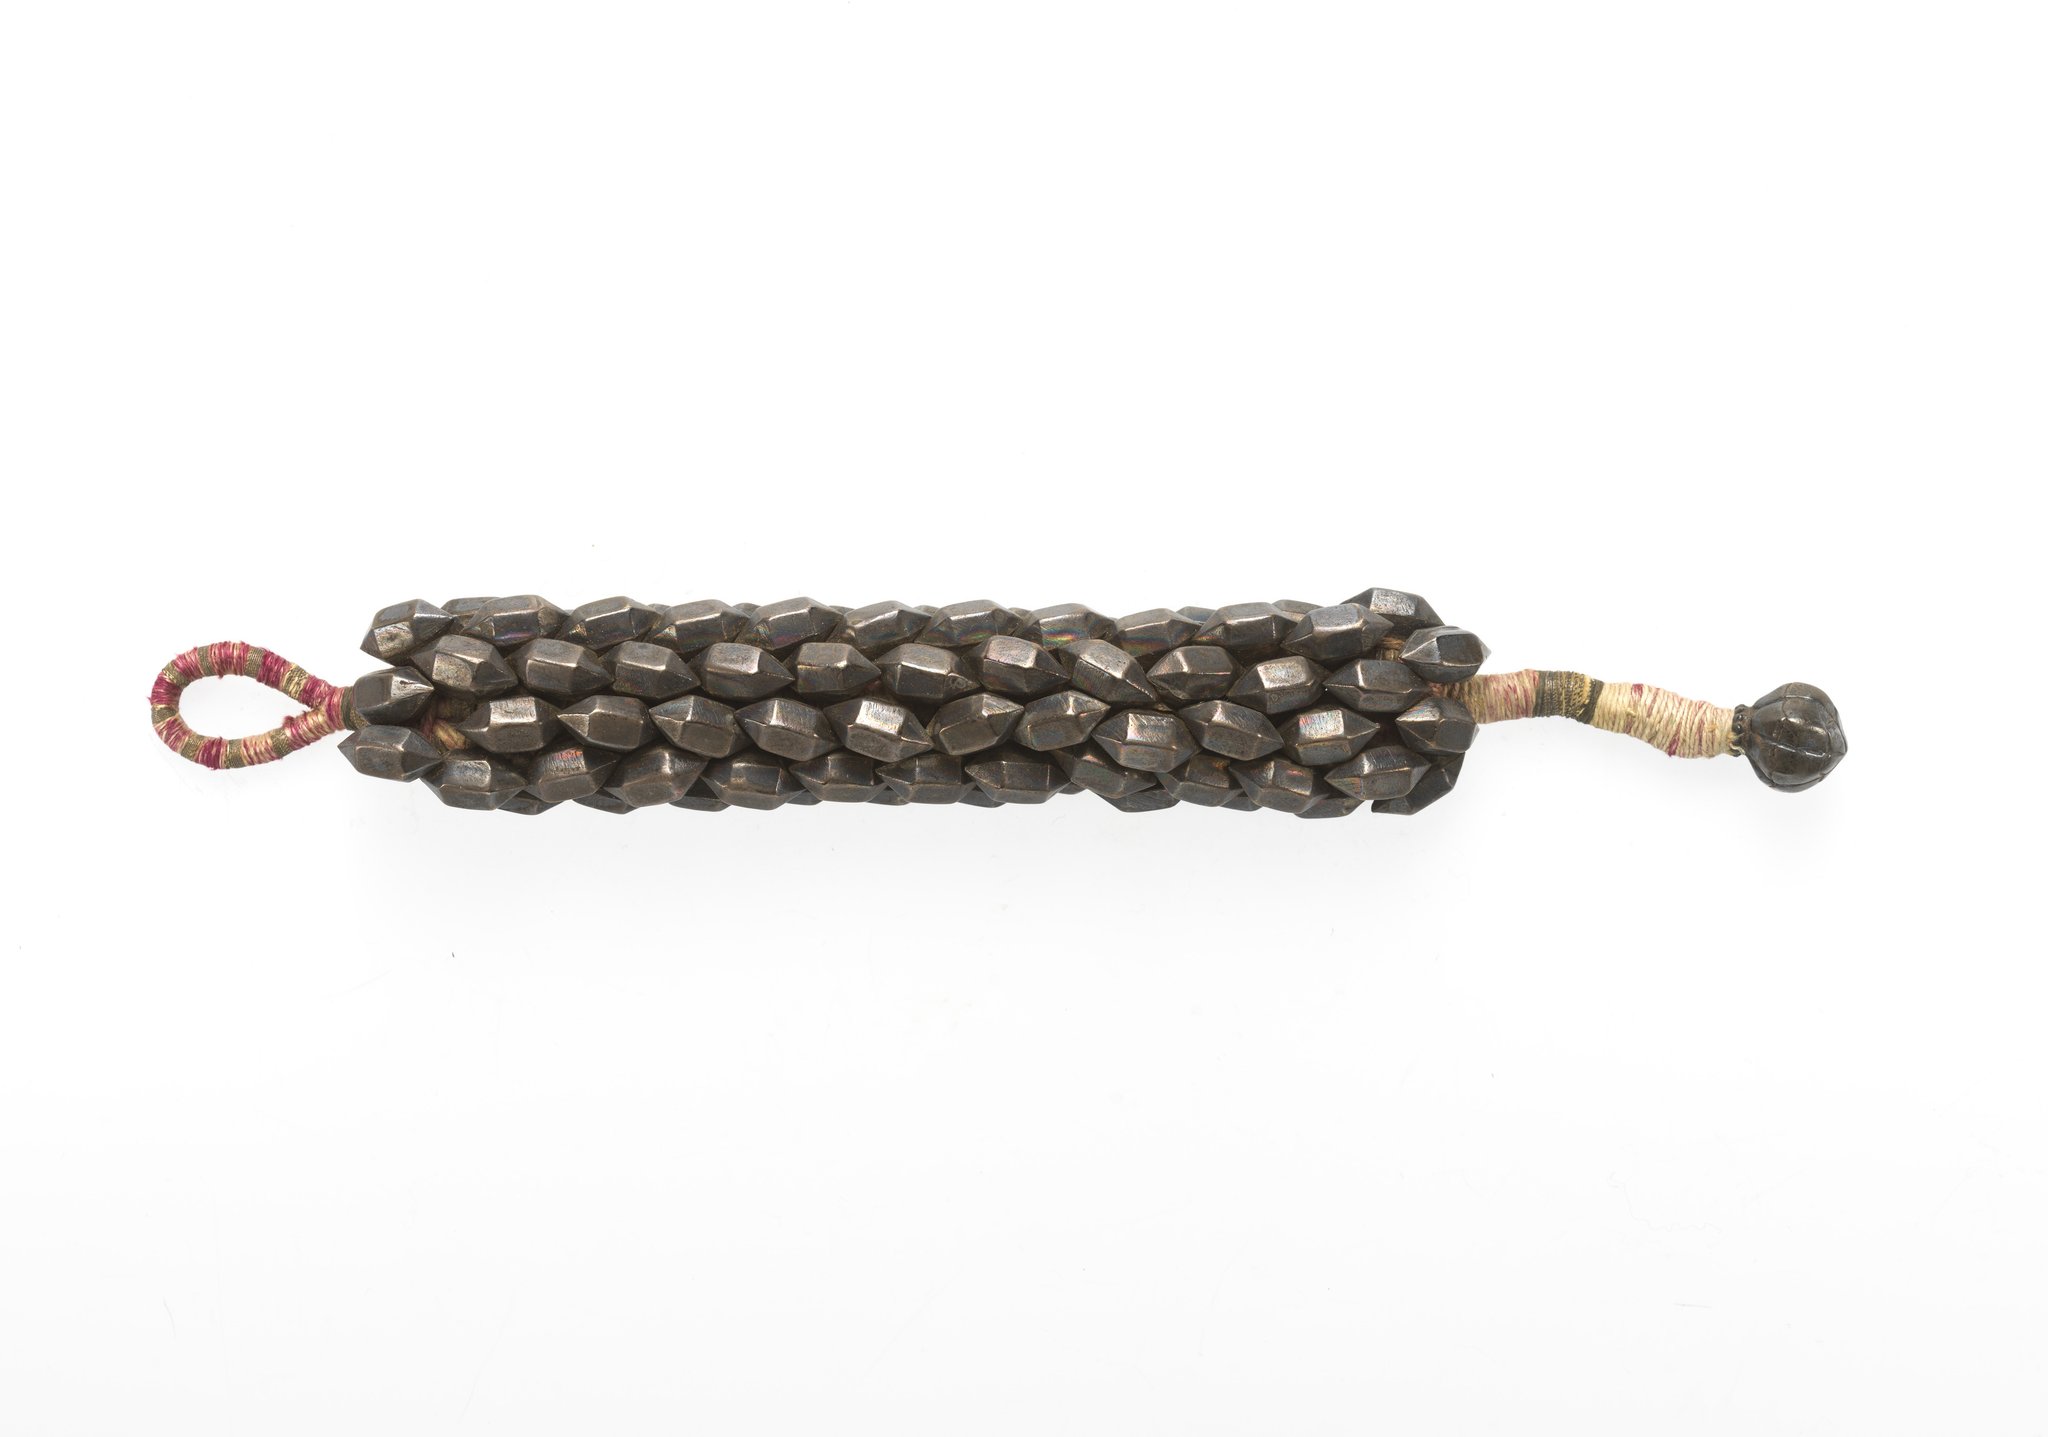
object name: bracelet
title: Bracelet (Pahunchi)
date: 1801-1900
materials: silver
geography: india